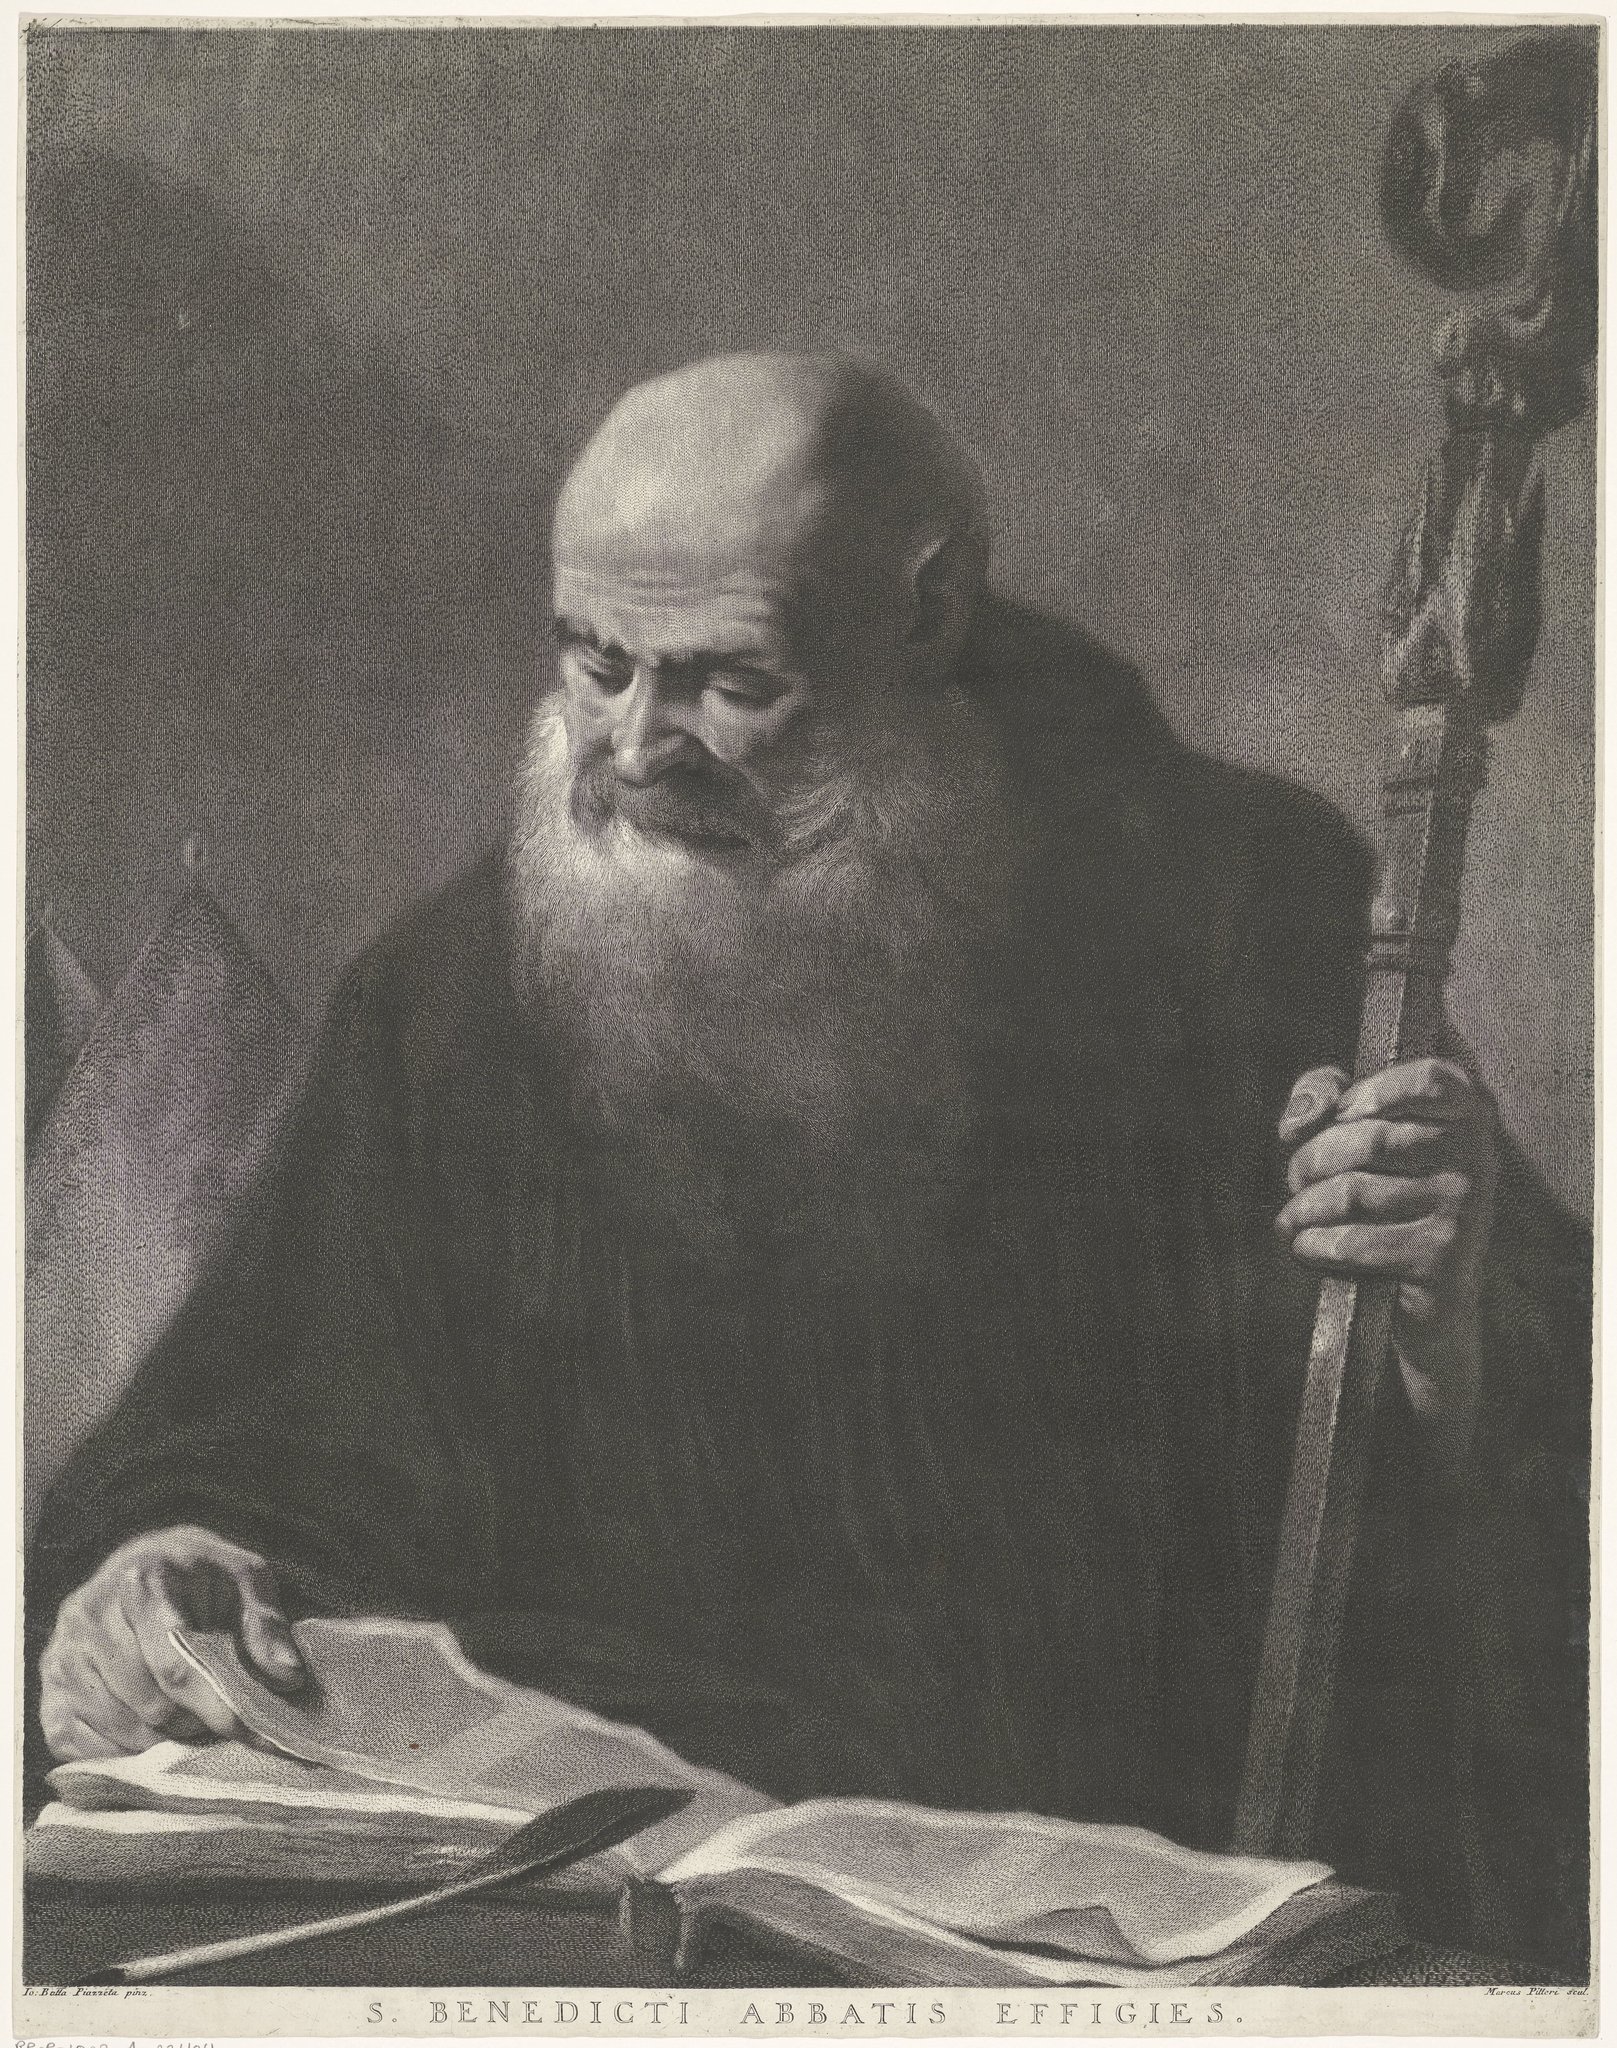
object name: print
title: S. Benedicti Abbatis Effigies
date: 1712-1786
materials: paper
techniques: engraving, etching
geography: venice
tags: benedict of nurcia, abbot of monte cassino and founder of the benedictine order; possible attributes: aspergillum, book, cup (sometimes broken), raven with loaf, sieve (or tray)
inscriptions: collector's mark: Lugt 2228